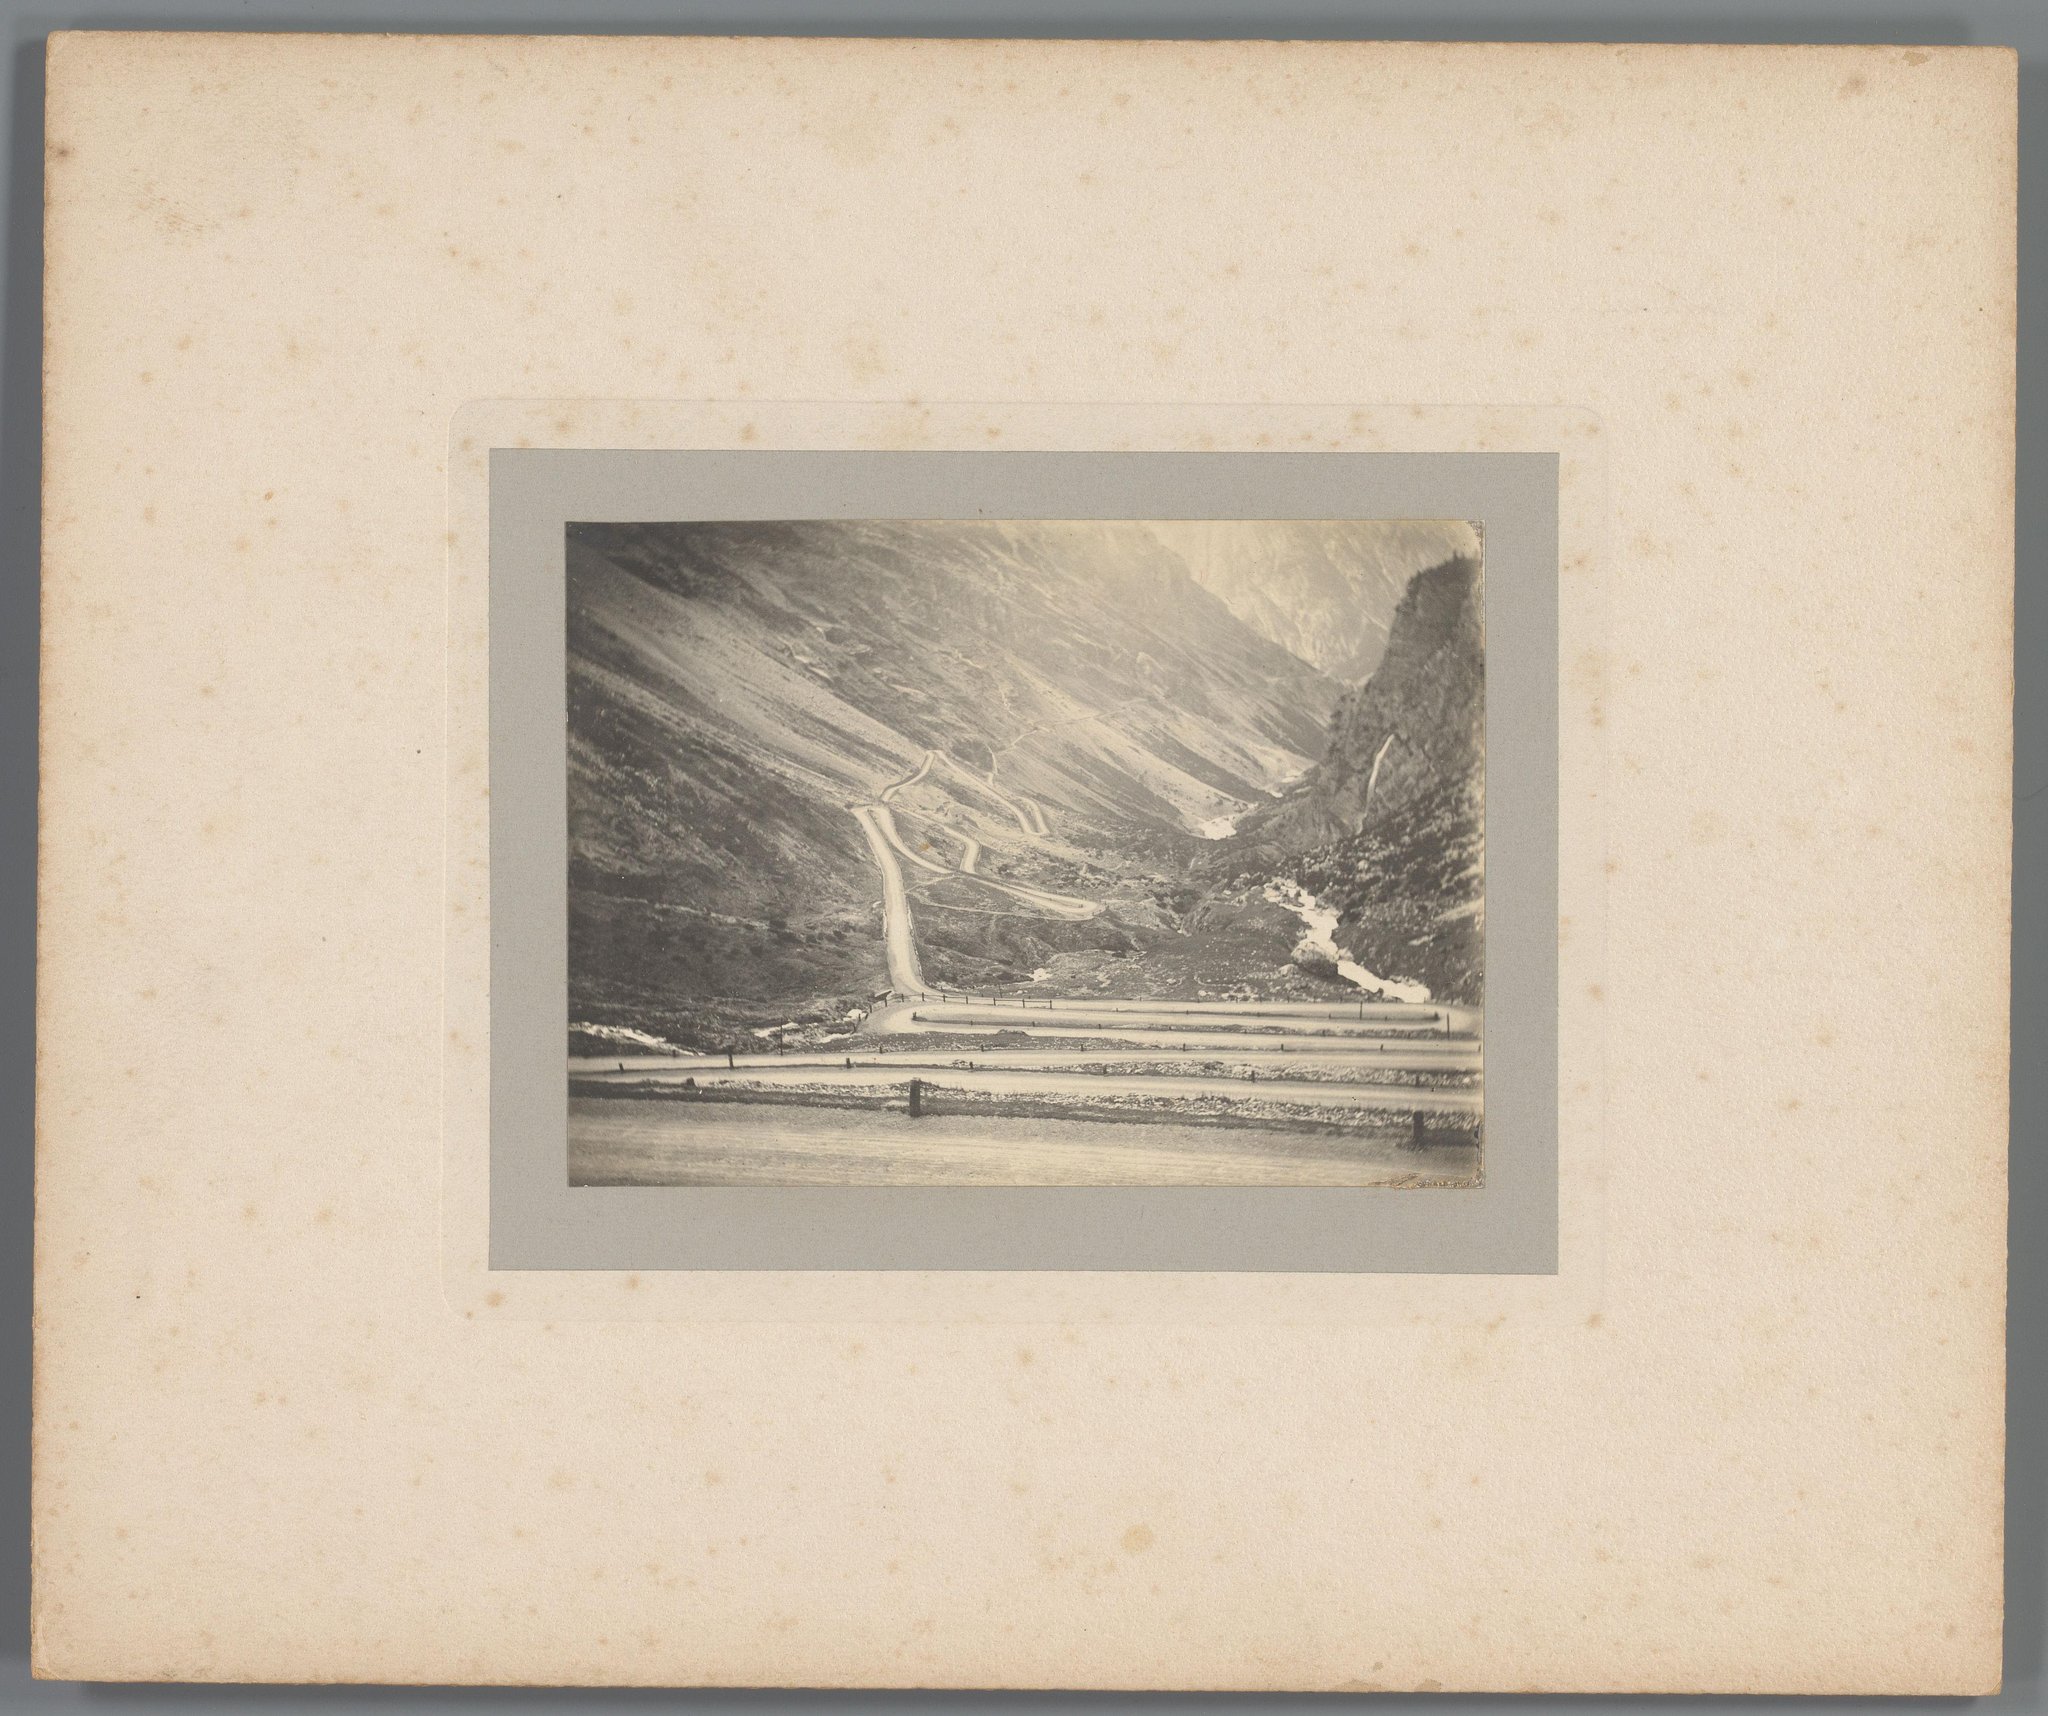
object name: photograph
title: Stilfser-Joch, van Bagni-di-Bormio uit gezien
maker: françois buys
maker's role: advocaat, amateurfotograaf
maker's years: 1871-1934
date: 1905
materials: paper, cardboard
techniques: gelatin silver print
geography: stelviopas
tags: dale, valley, mountains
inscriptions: inscription: ‘Stilfser-Joch/ van Bagni-di-Bormio uit gezien’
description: Deze foto maakt deel uit van een groep van 38 foto's.